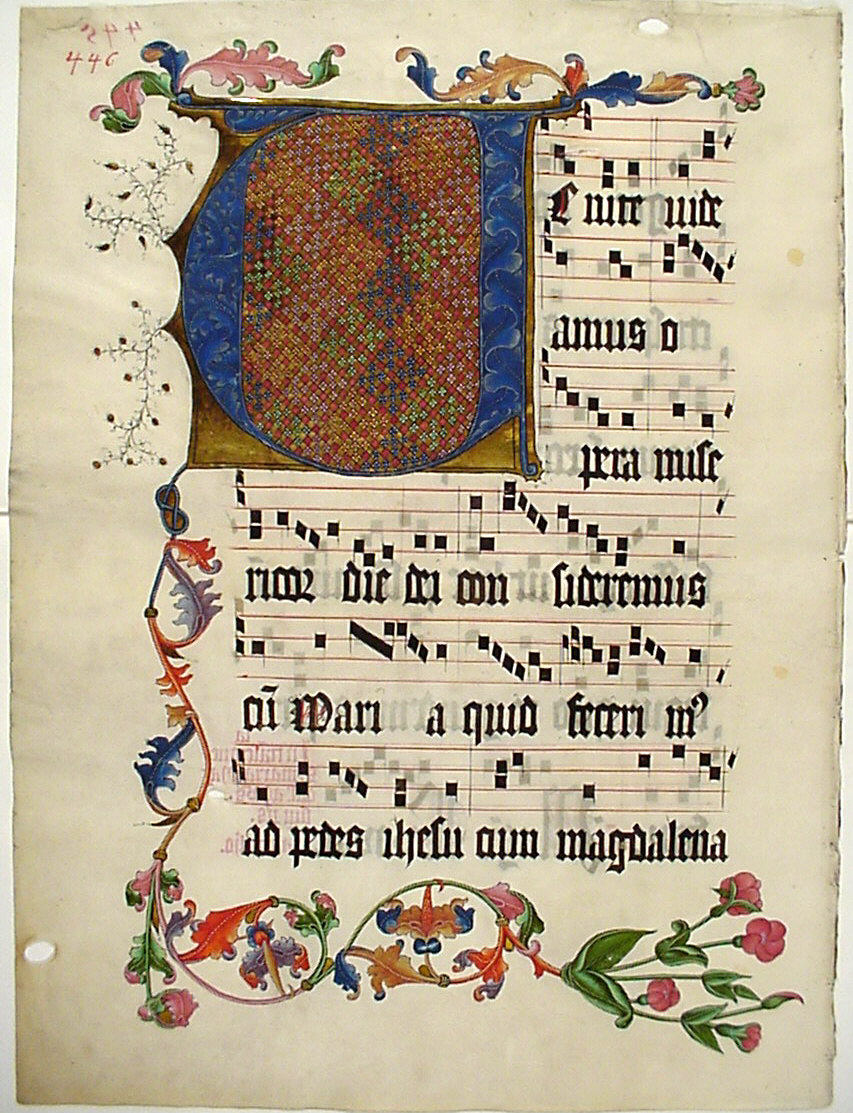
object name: antiphonary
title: Manuscript Leaf with the Initial V, from an Antiphonary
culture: german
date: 1425-1450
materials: ink, metal leaf, parchment, paint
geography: germany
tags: music